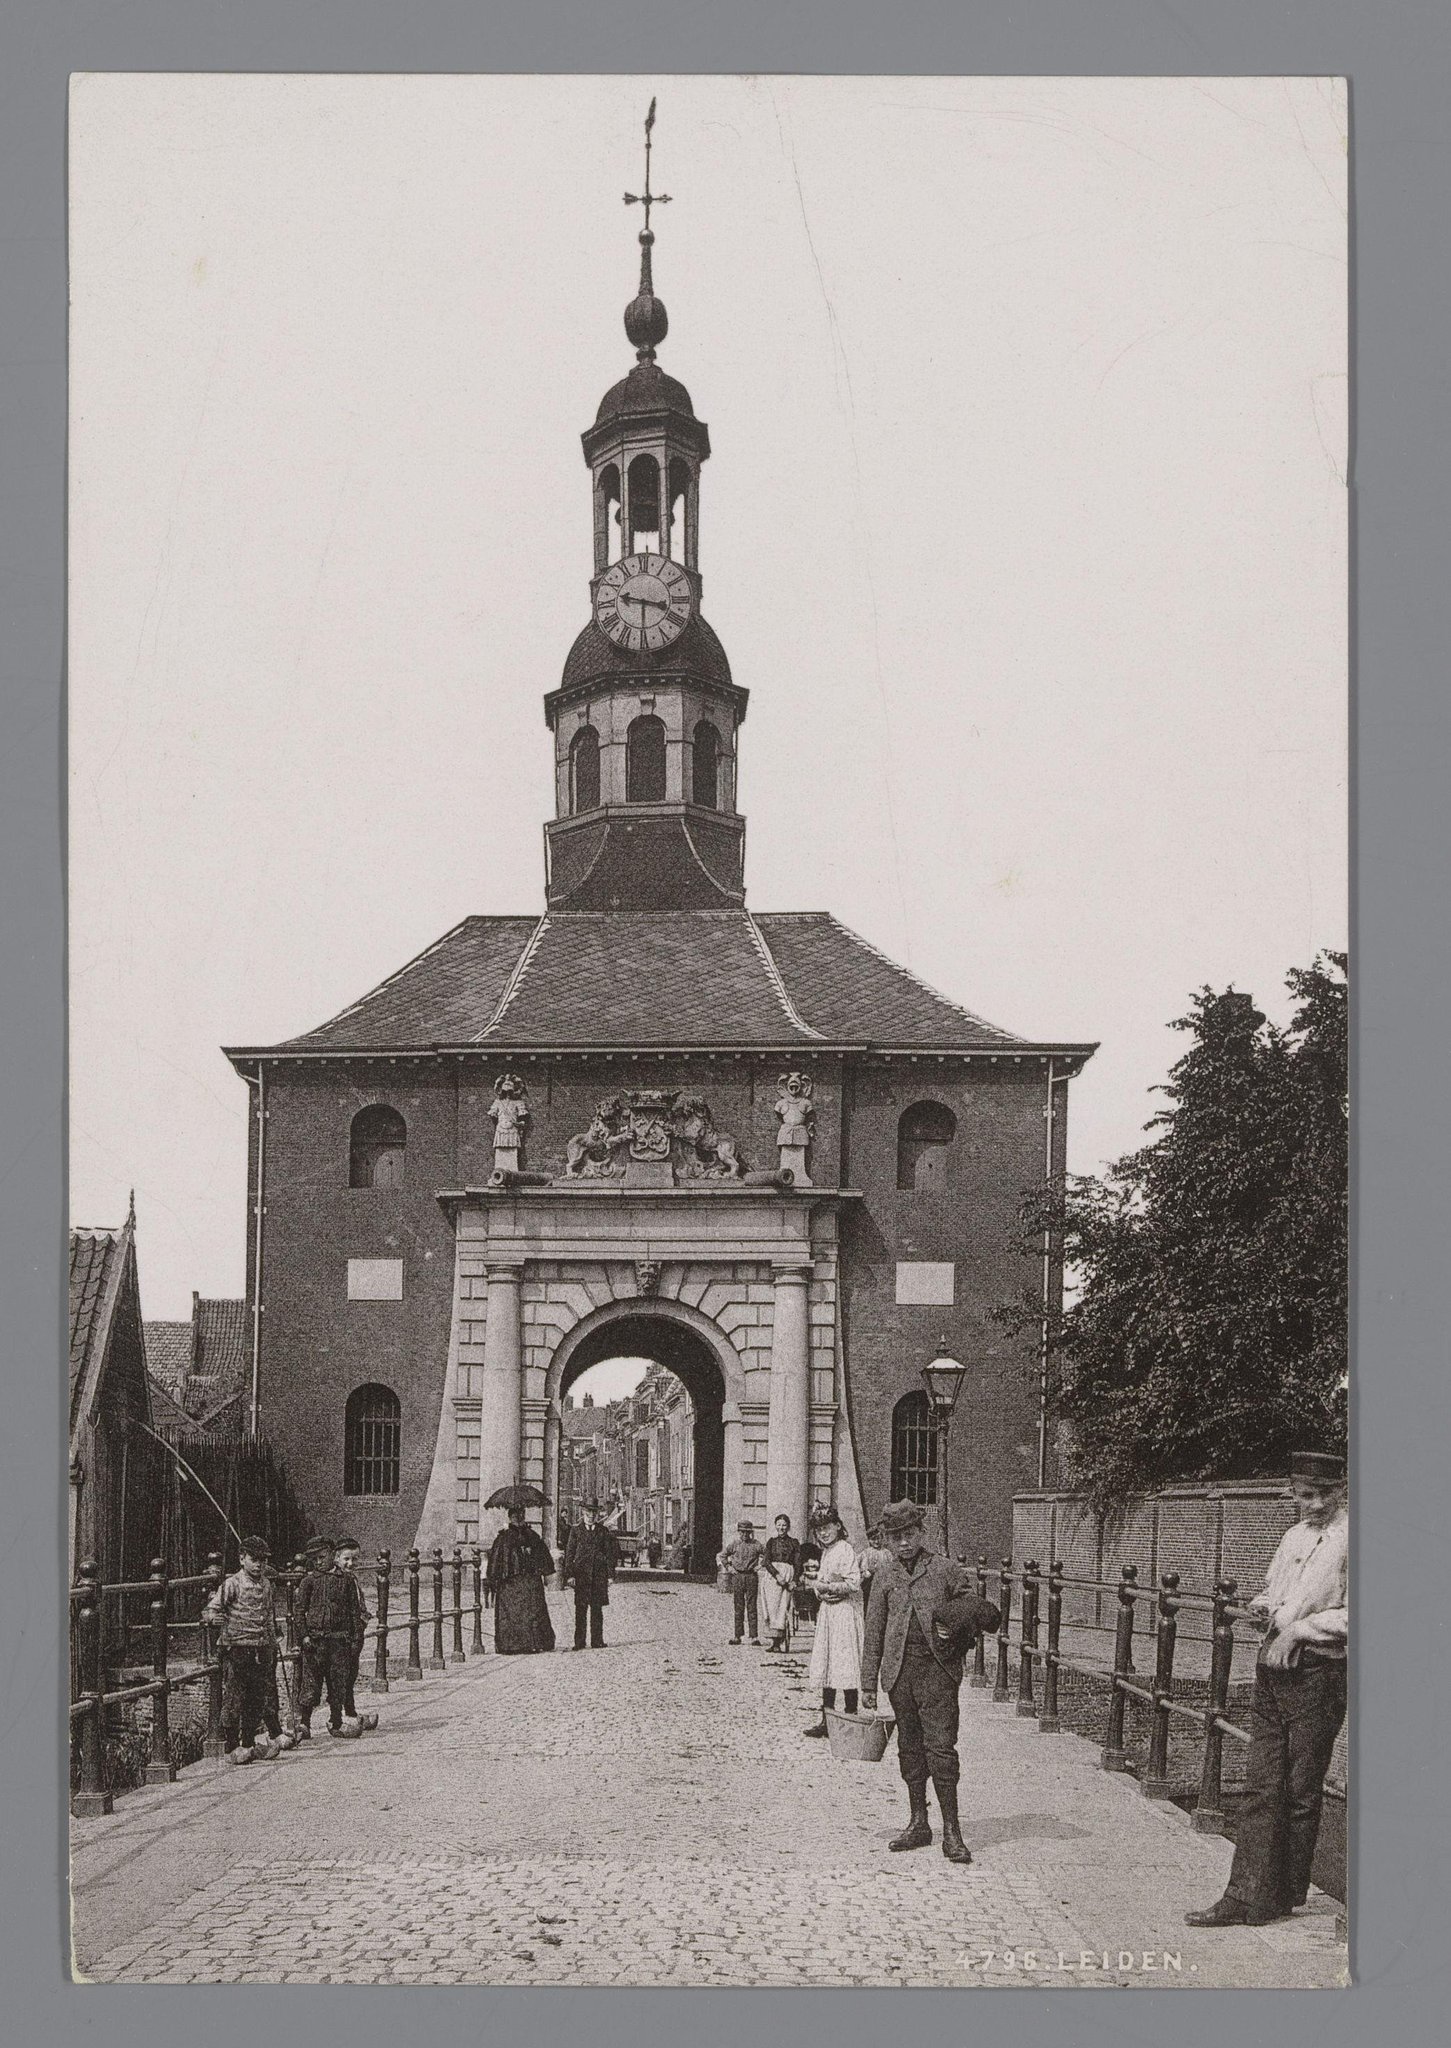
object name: photomechanical print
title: Gezicht op de Zijlpoort te Leiden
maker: Anonymous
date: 1880-1920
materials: paper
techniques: photograph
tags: city-gate (+ city(-scape) with figures, staffage)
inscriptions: inscription: ‘4796. Leiden’